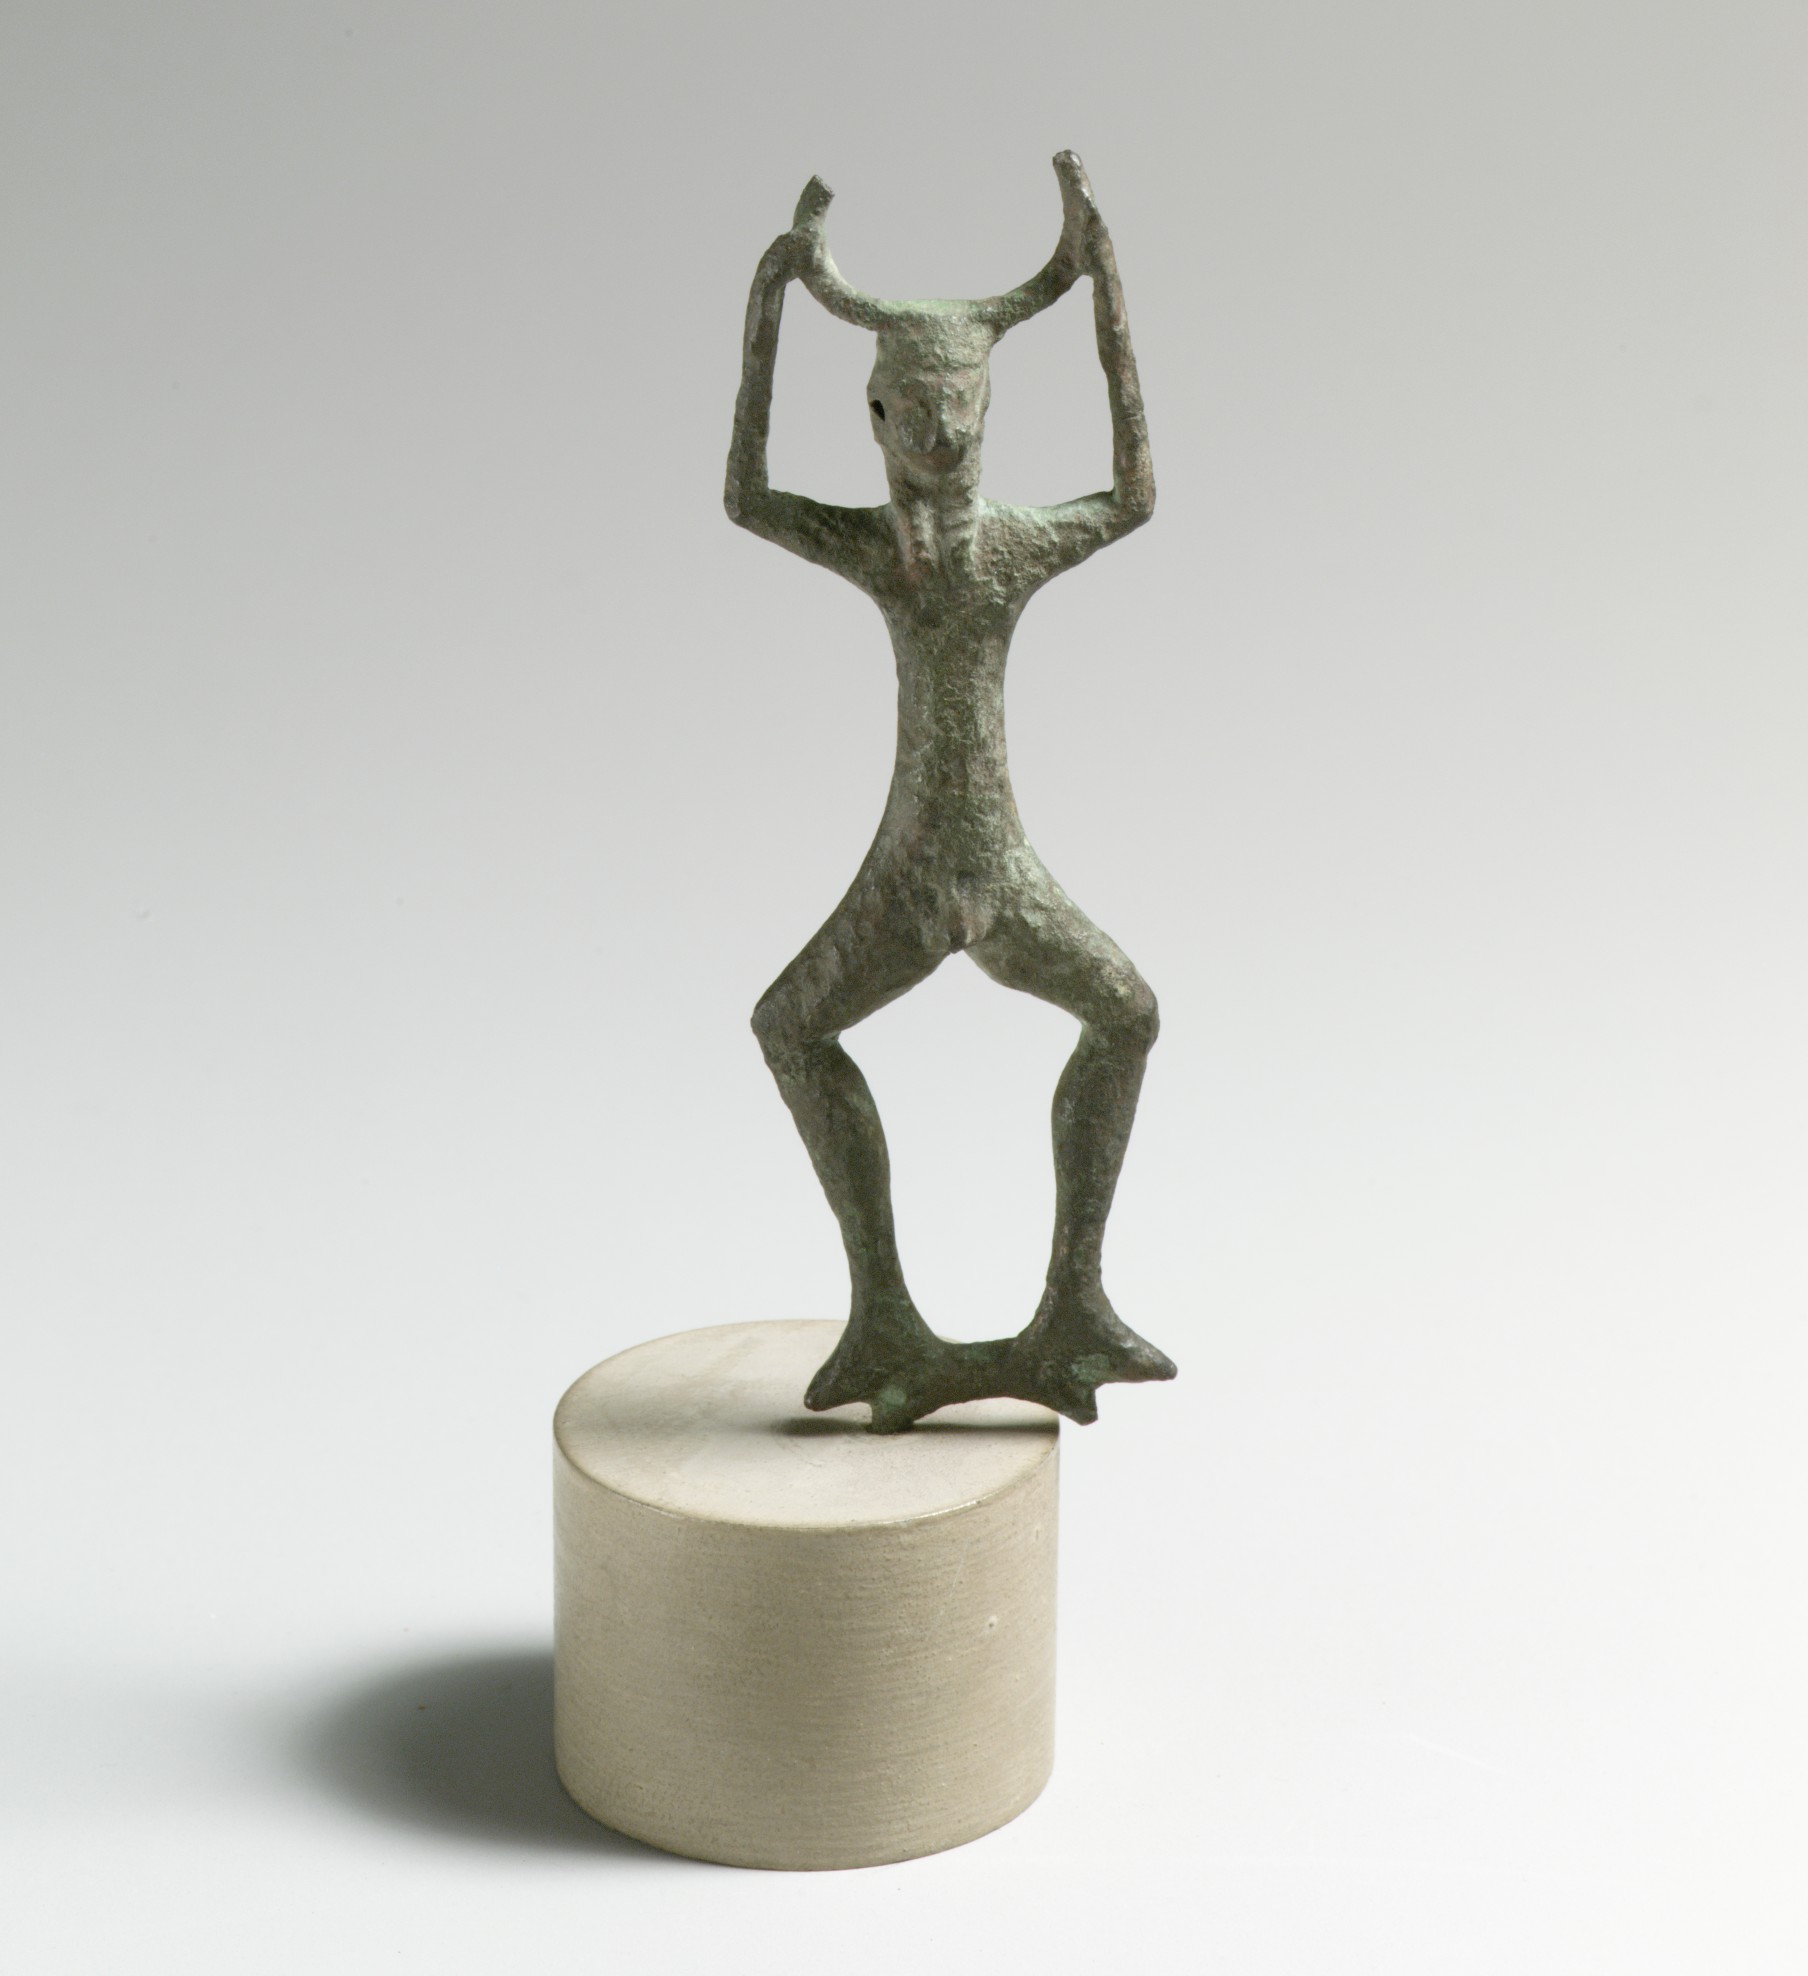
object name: statuette of a man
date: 7000 BCE-330 CE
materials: bronze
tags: men